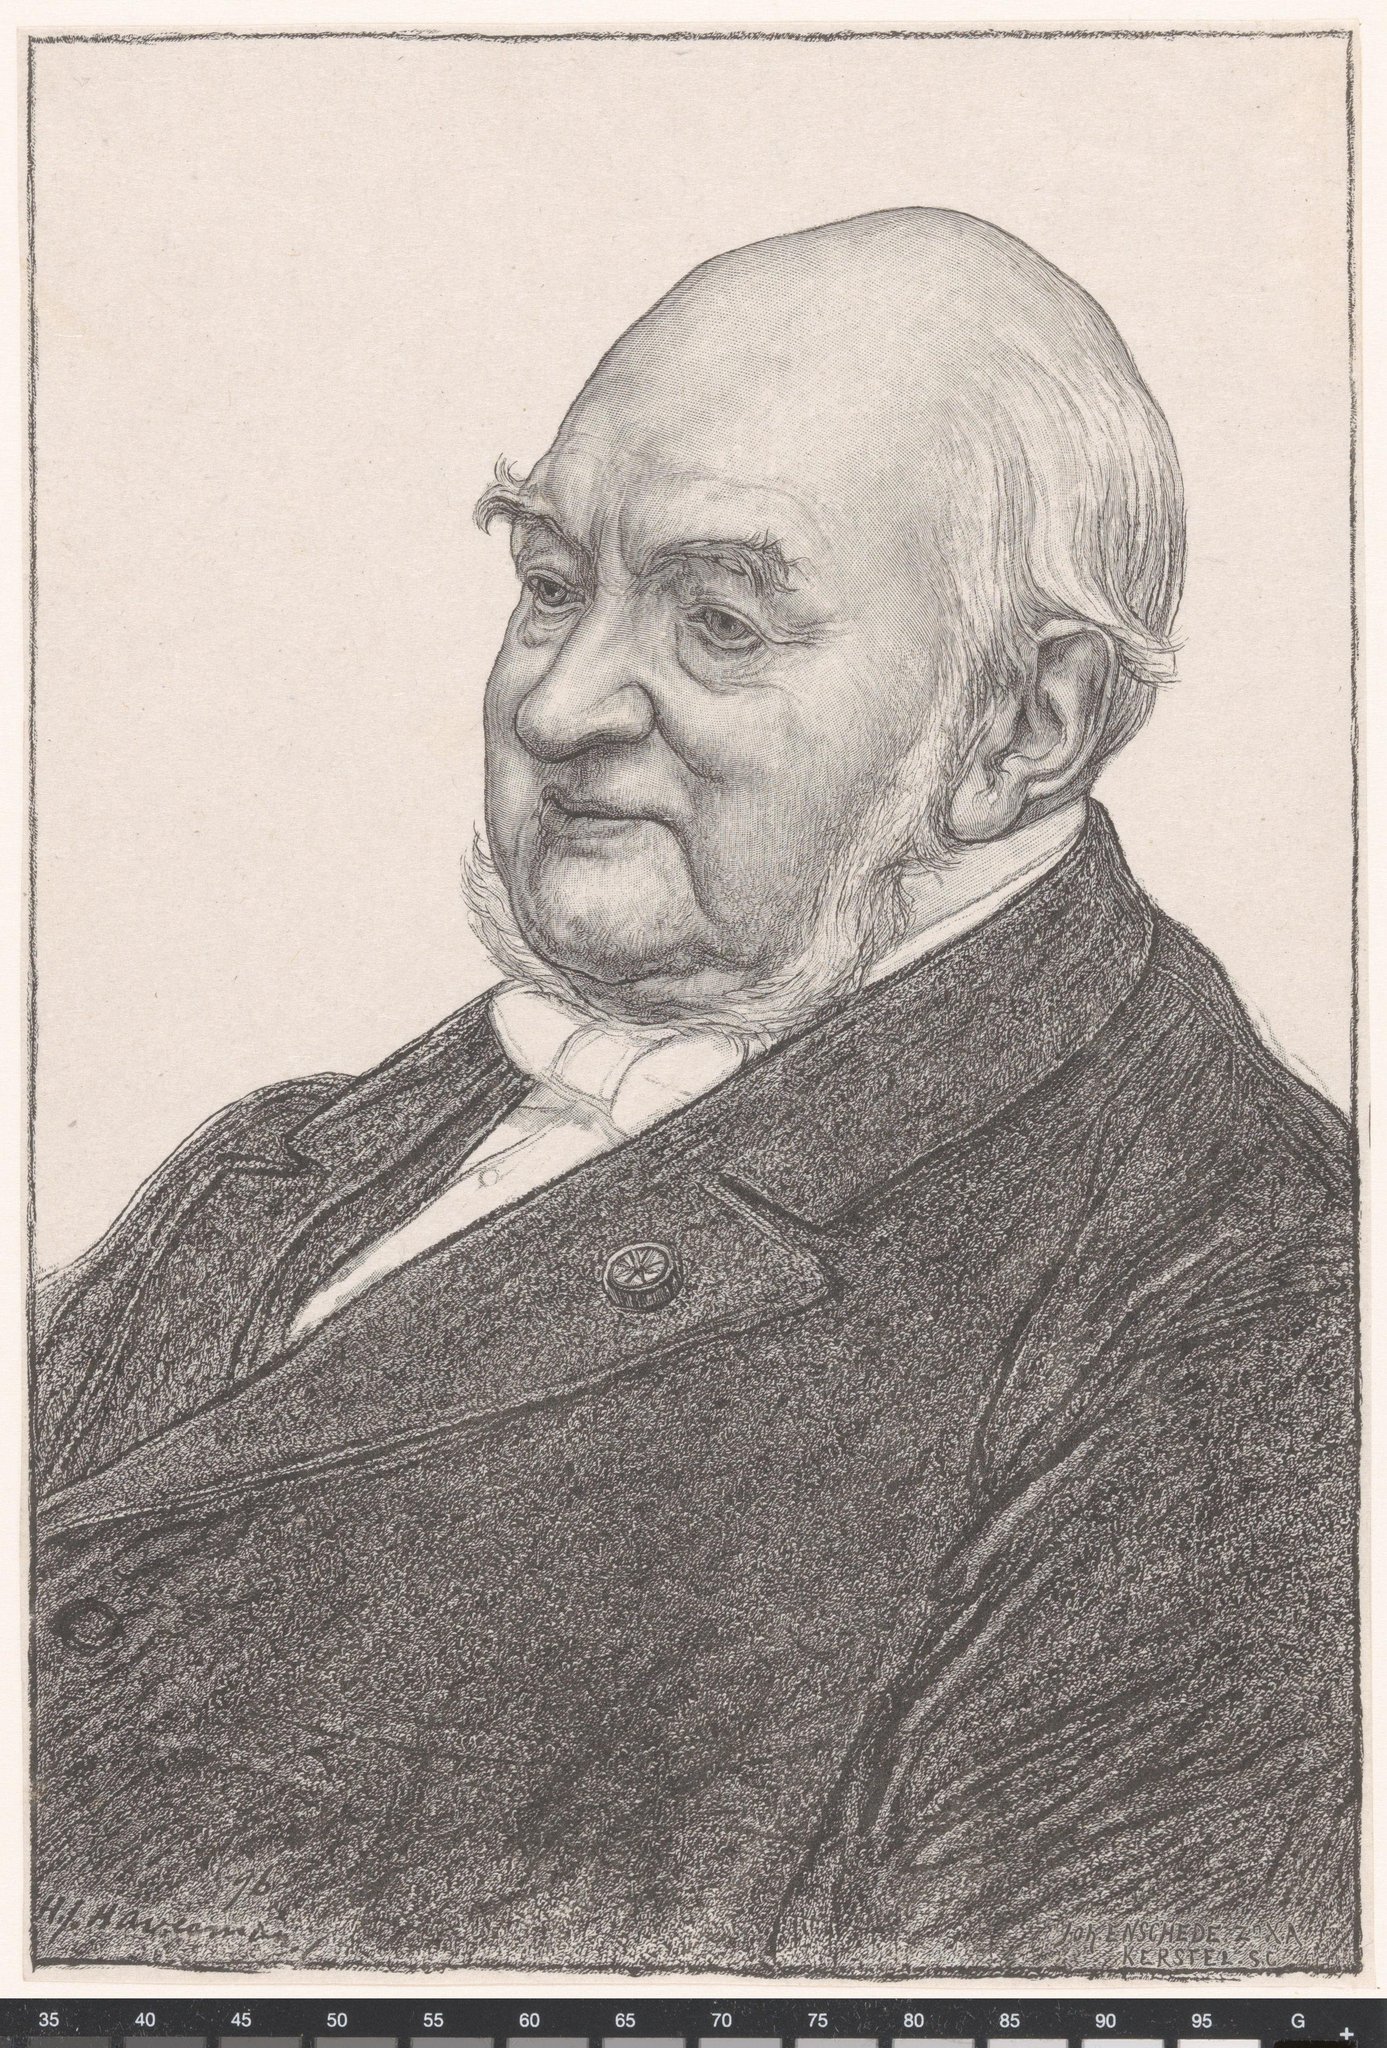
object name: print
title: Portret van een onbekende man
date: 1896-1936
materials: paper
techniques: lithograph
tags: sideburns, anonymous historical person portrayed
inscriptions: collector's mark: Lugt 2228